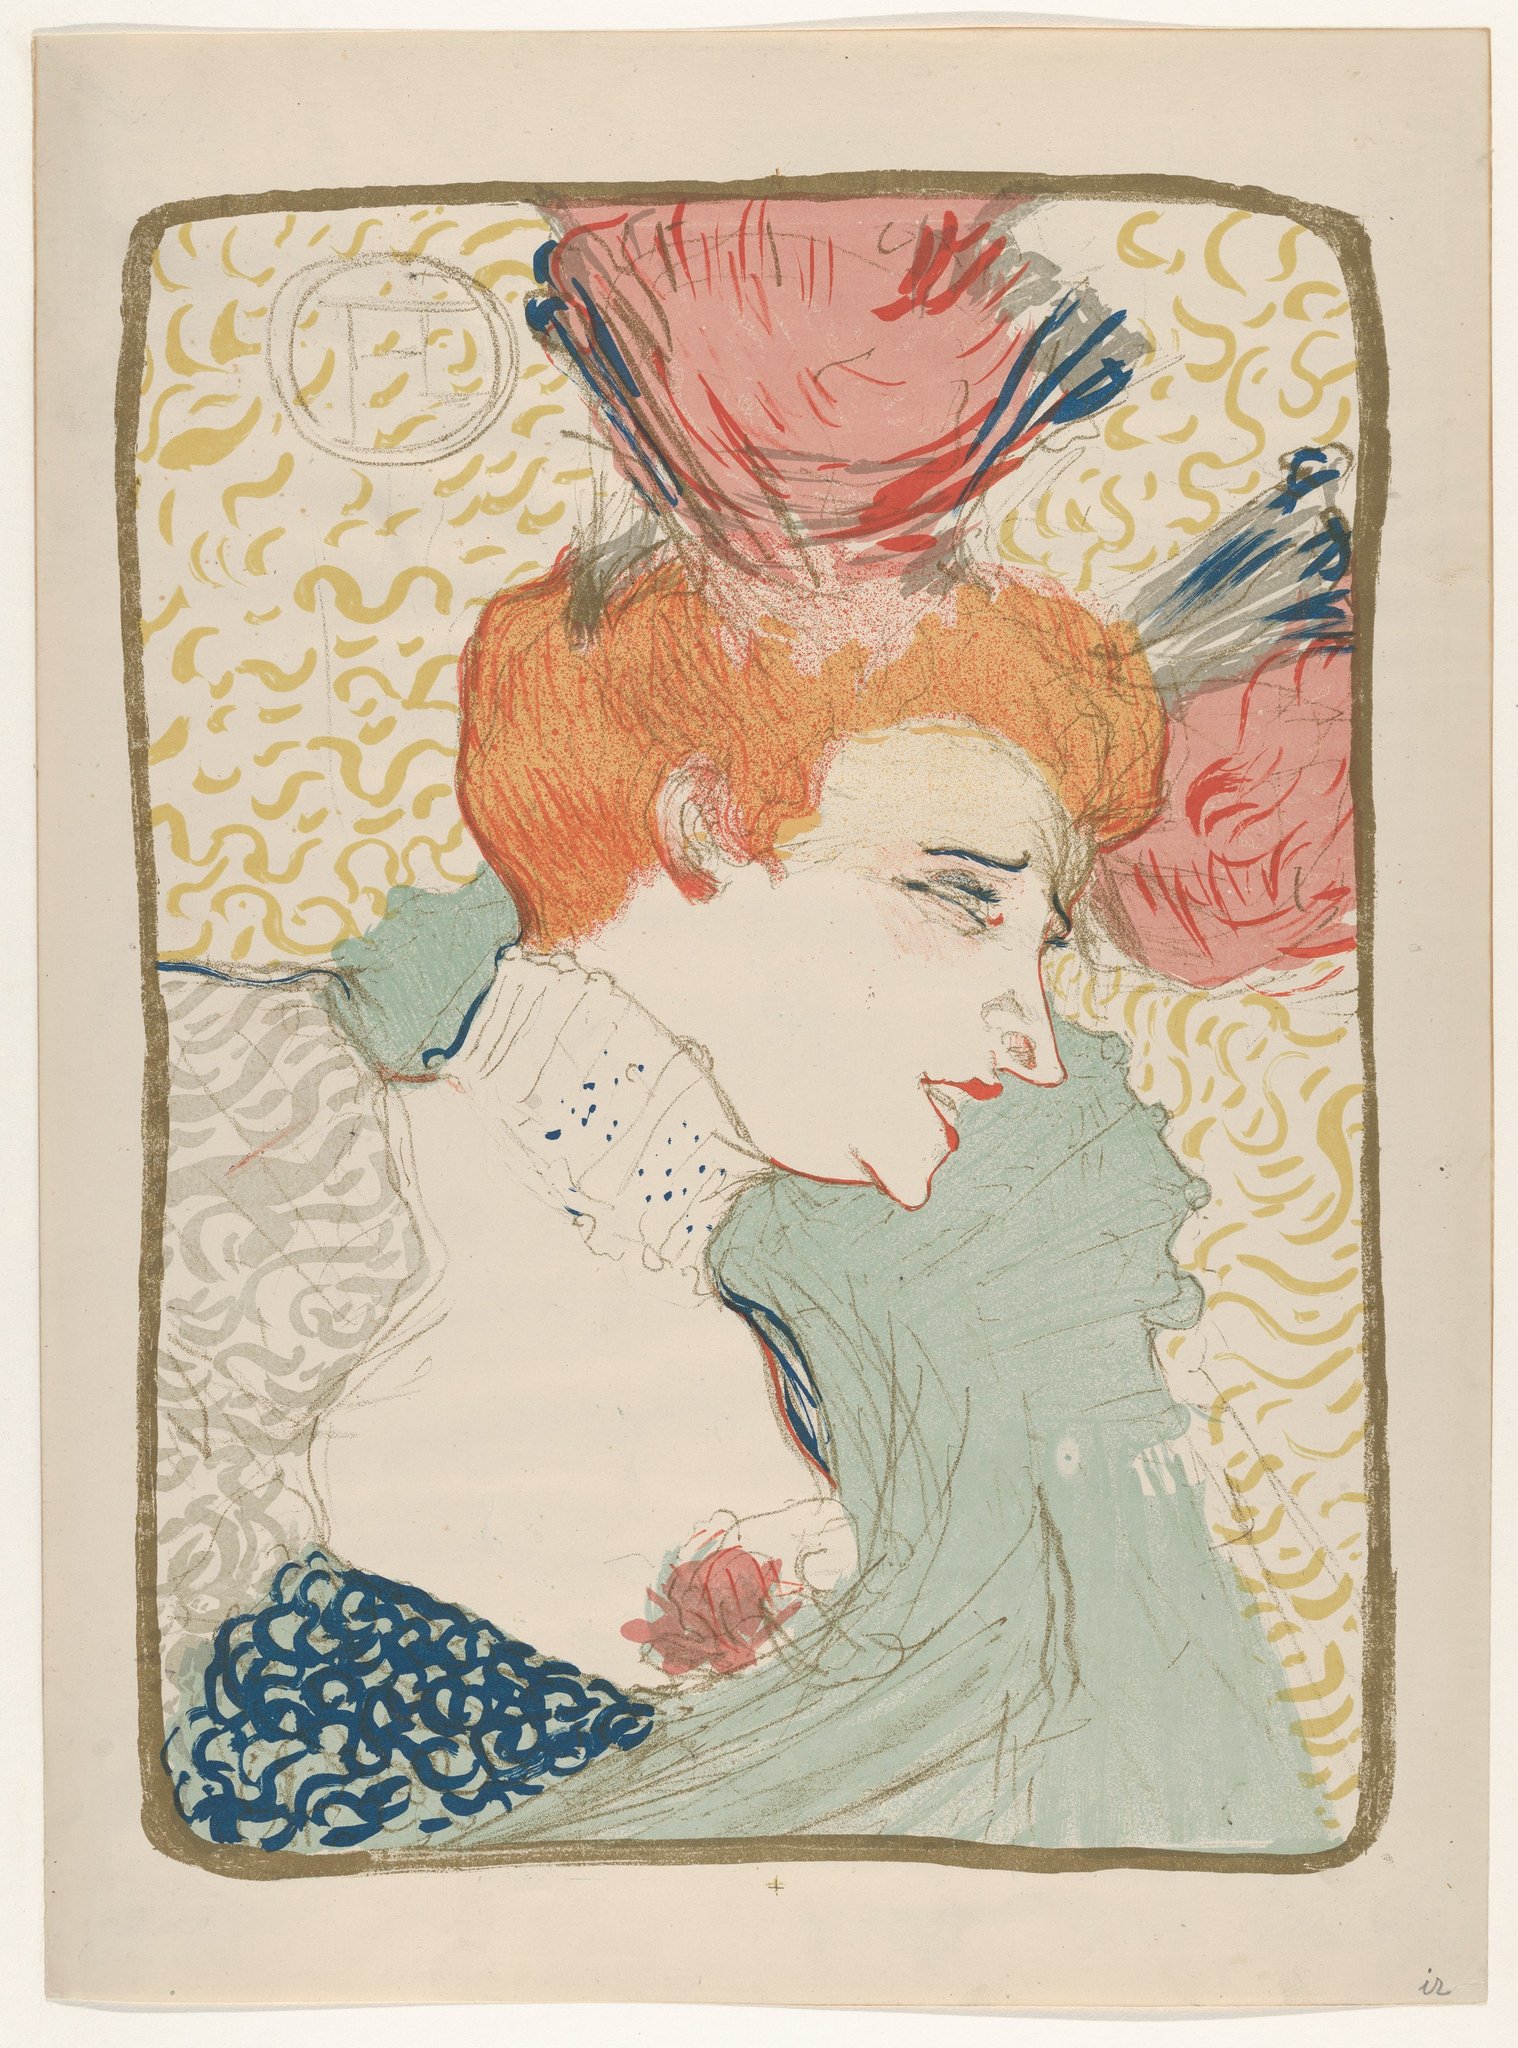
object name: print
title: Portrait Bust of Mademoiselle Marcelle Lender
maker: henri de toulouse-lautrec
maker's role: artist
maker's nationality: french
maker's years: 1864-1901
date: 1895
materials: crayon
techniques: brush, lithograph, printing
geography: france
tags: women